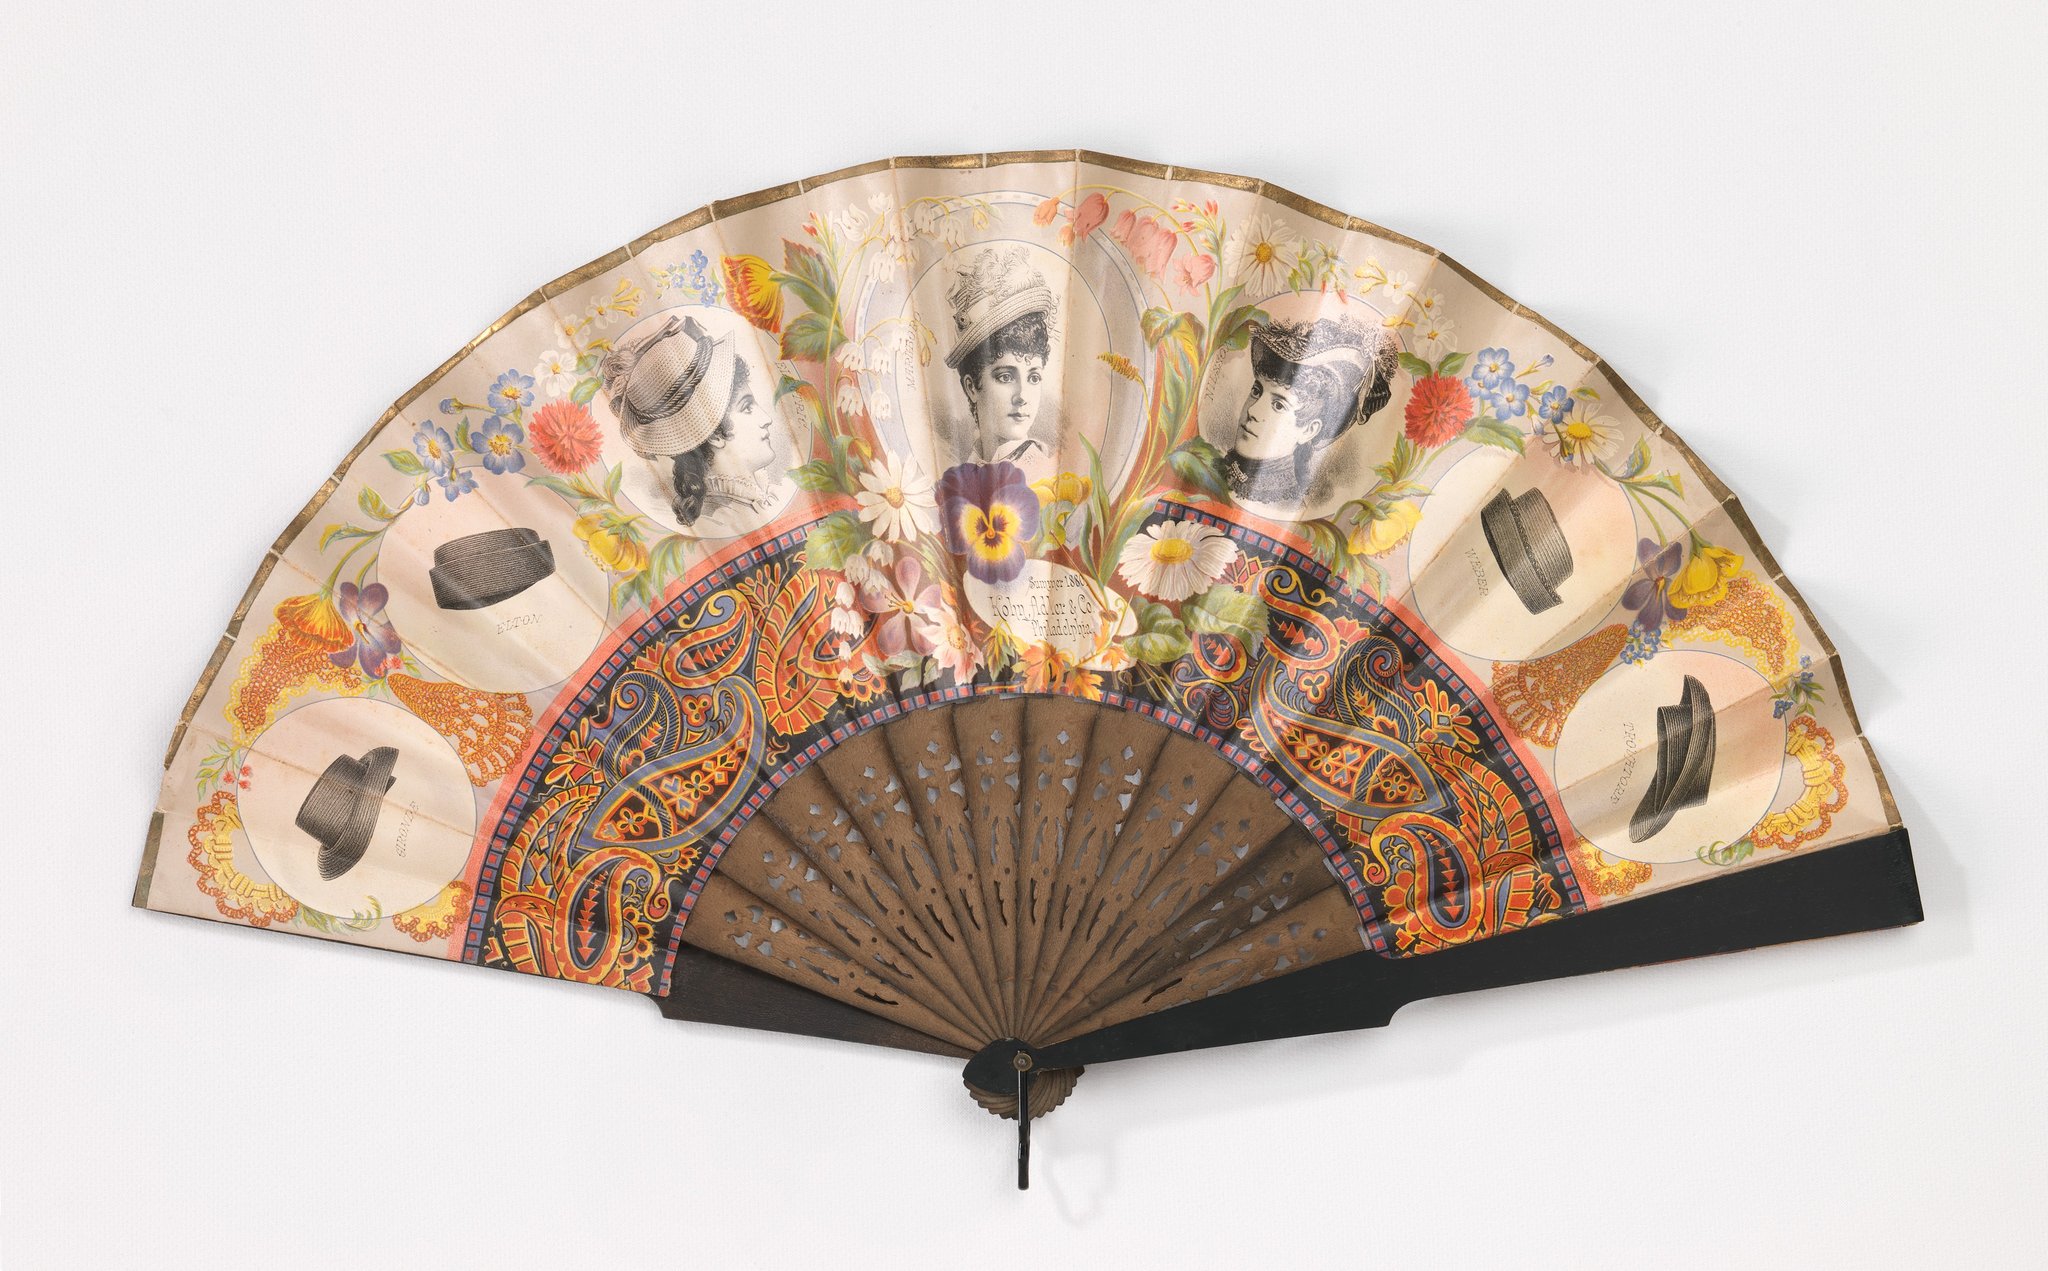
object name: fan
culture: american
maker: donaldson brothers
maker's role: designer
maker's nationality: american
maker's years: 1850-1870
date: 1880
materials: metal, paper, wood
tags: hats,portraits,women